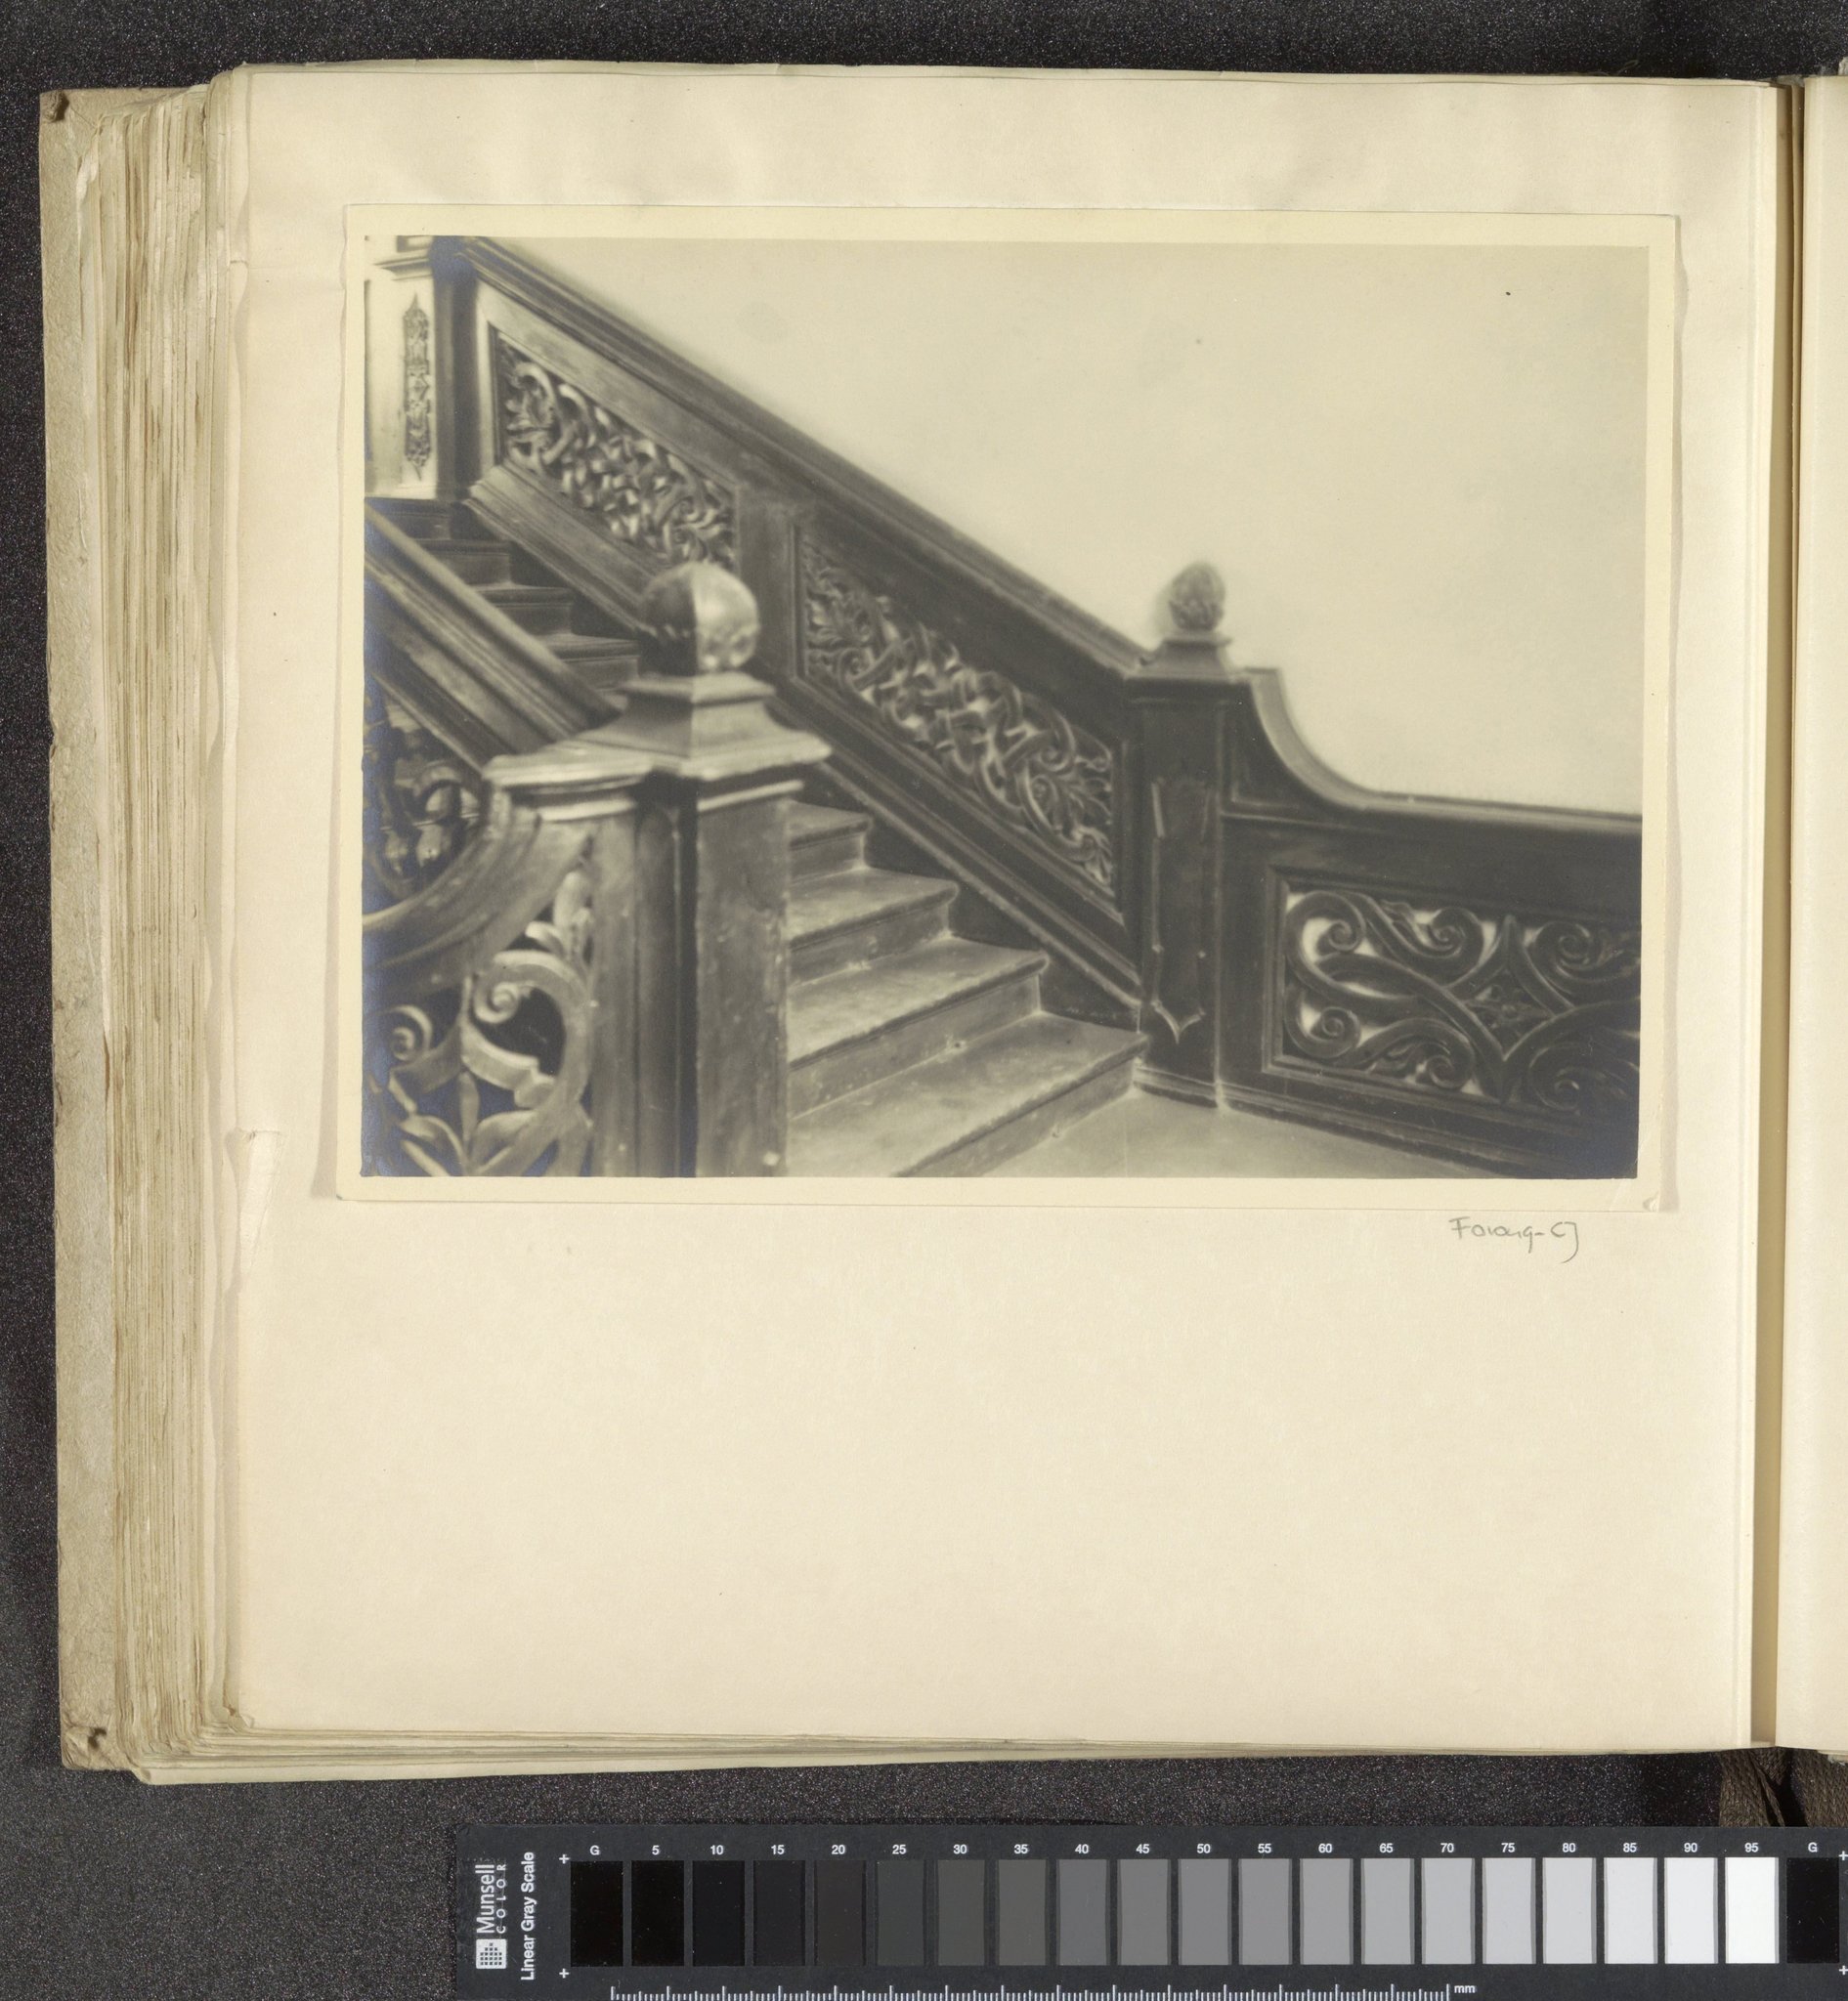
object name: photograph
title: Berwerkte houten trap in Schloss Spetzgart, nevenvestiging van Schule Schloss Salem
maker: Anonymous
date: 1929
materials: photographic support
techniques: gelatin silver print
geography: spetzgart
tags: staircase, education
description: Onderdeel van Fotoalbum van Schule Schloss Salem.